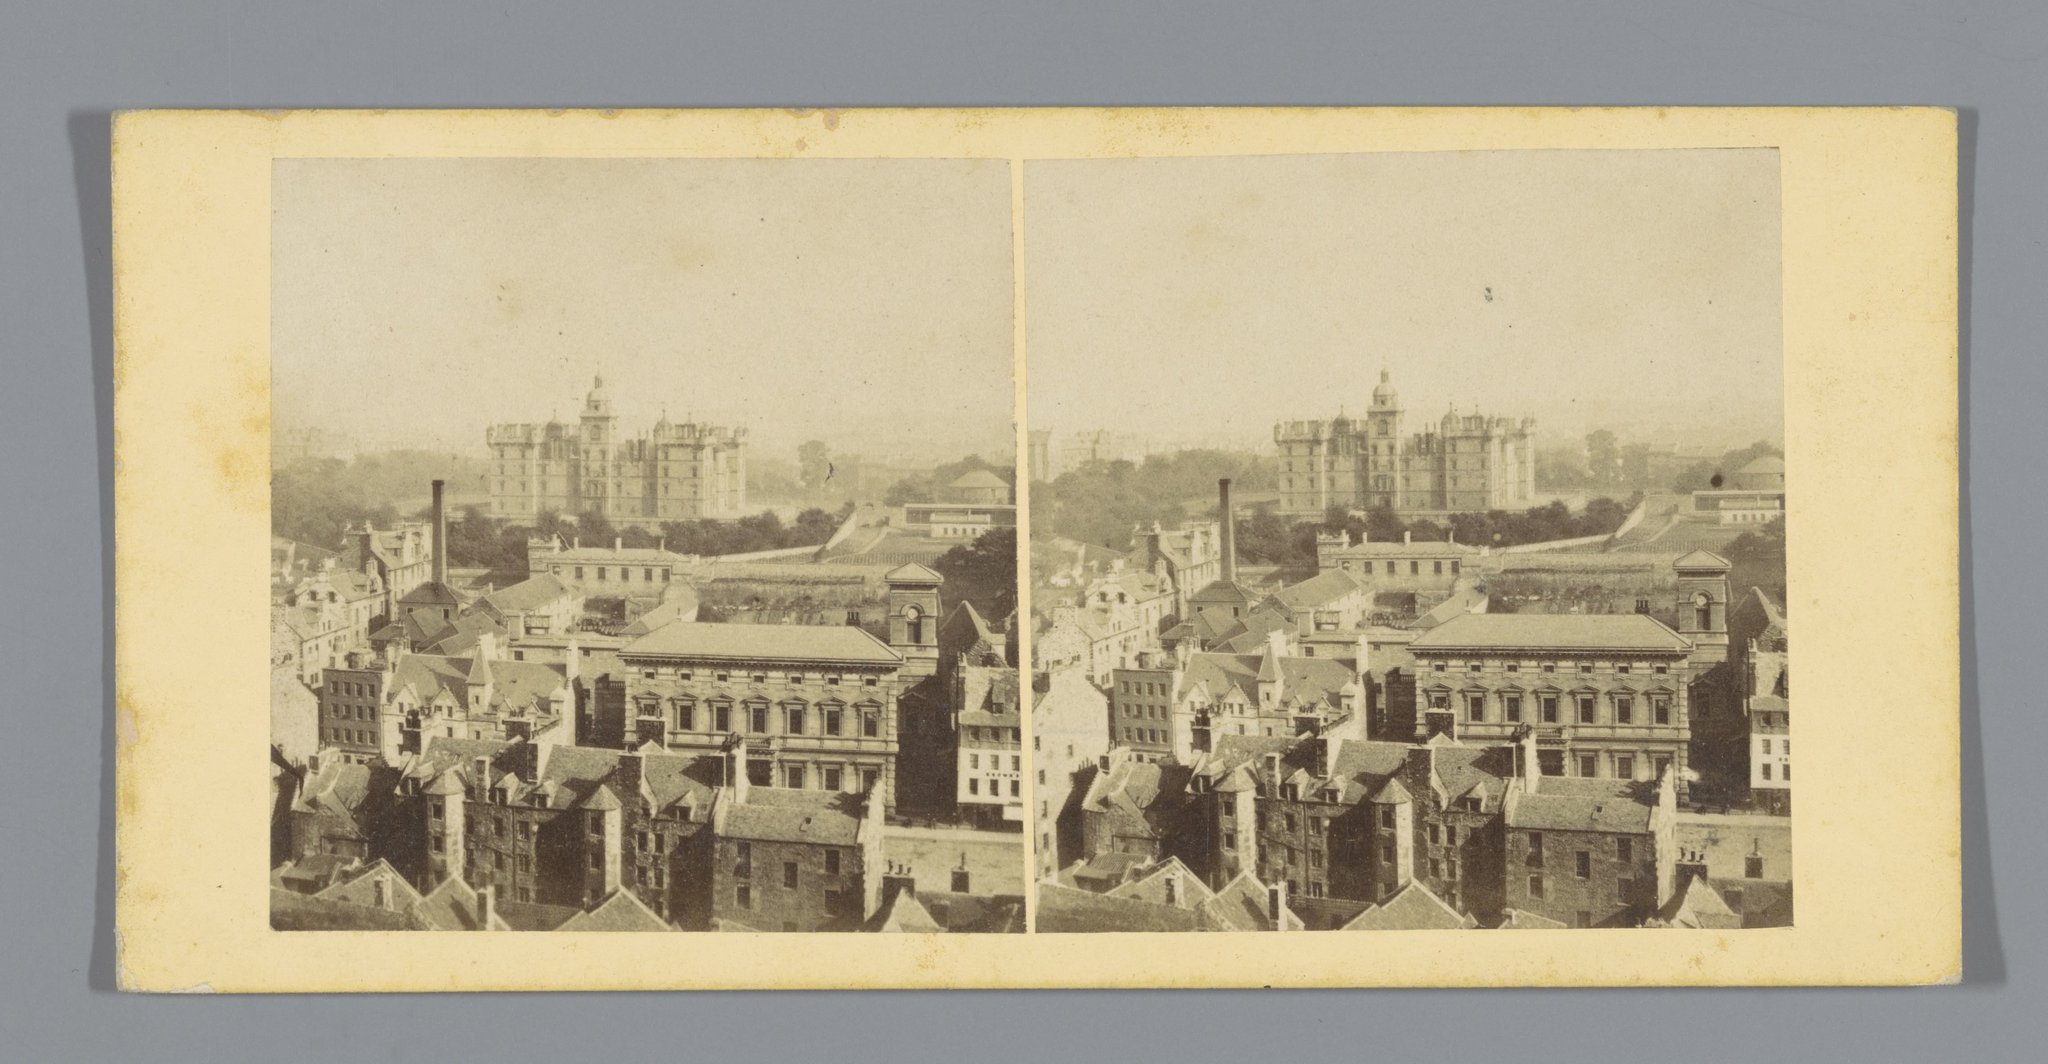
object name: stereograph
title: Gezicht op het George Heriot's Hospital in Edinburgh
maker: Anonymous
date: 1850-1880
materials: cardboard, photographic support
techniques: albumen print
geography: edinburgh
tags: hospital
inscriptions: number: ‘133’, inscription: ‘George Heriot's Hospital, Edinburgh (...)’